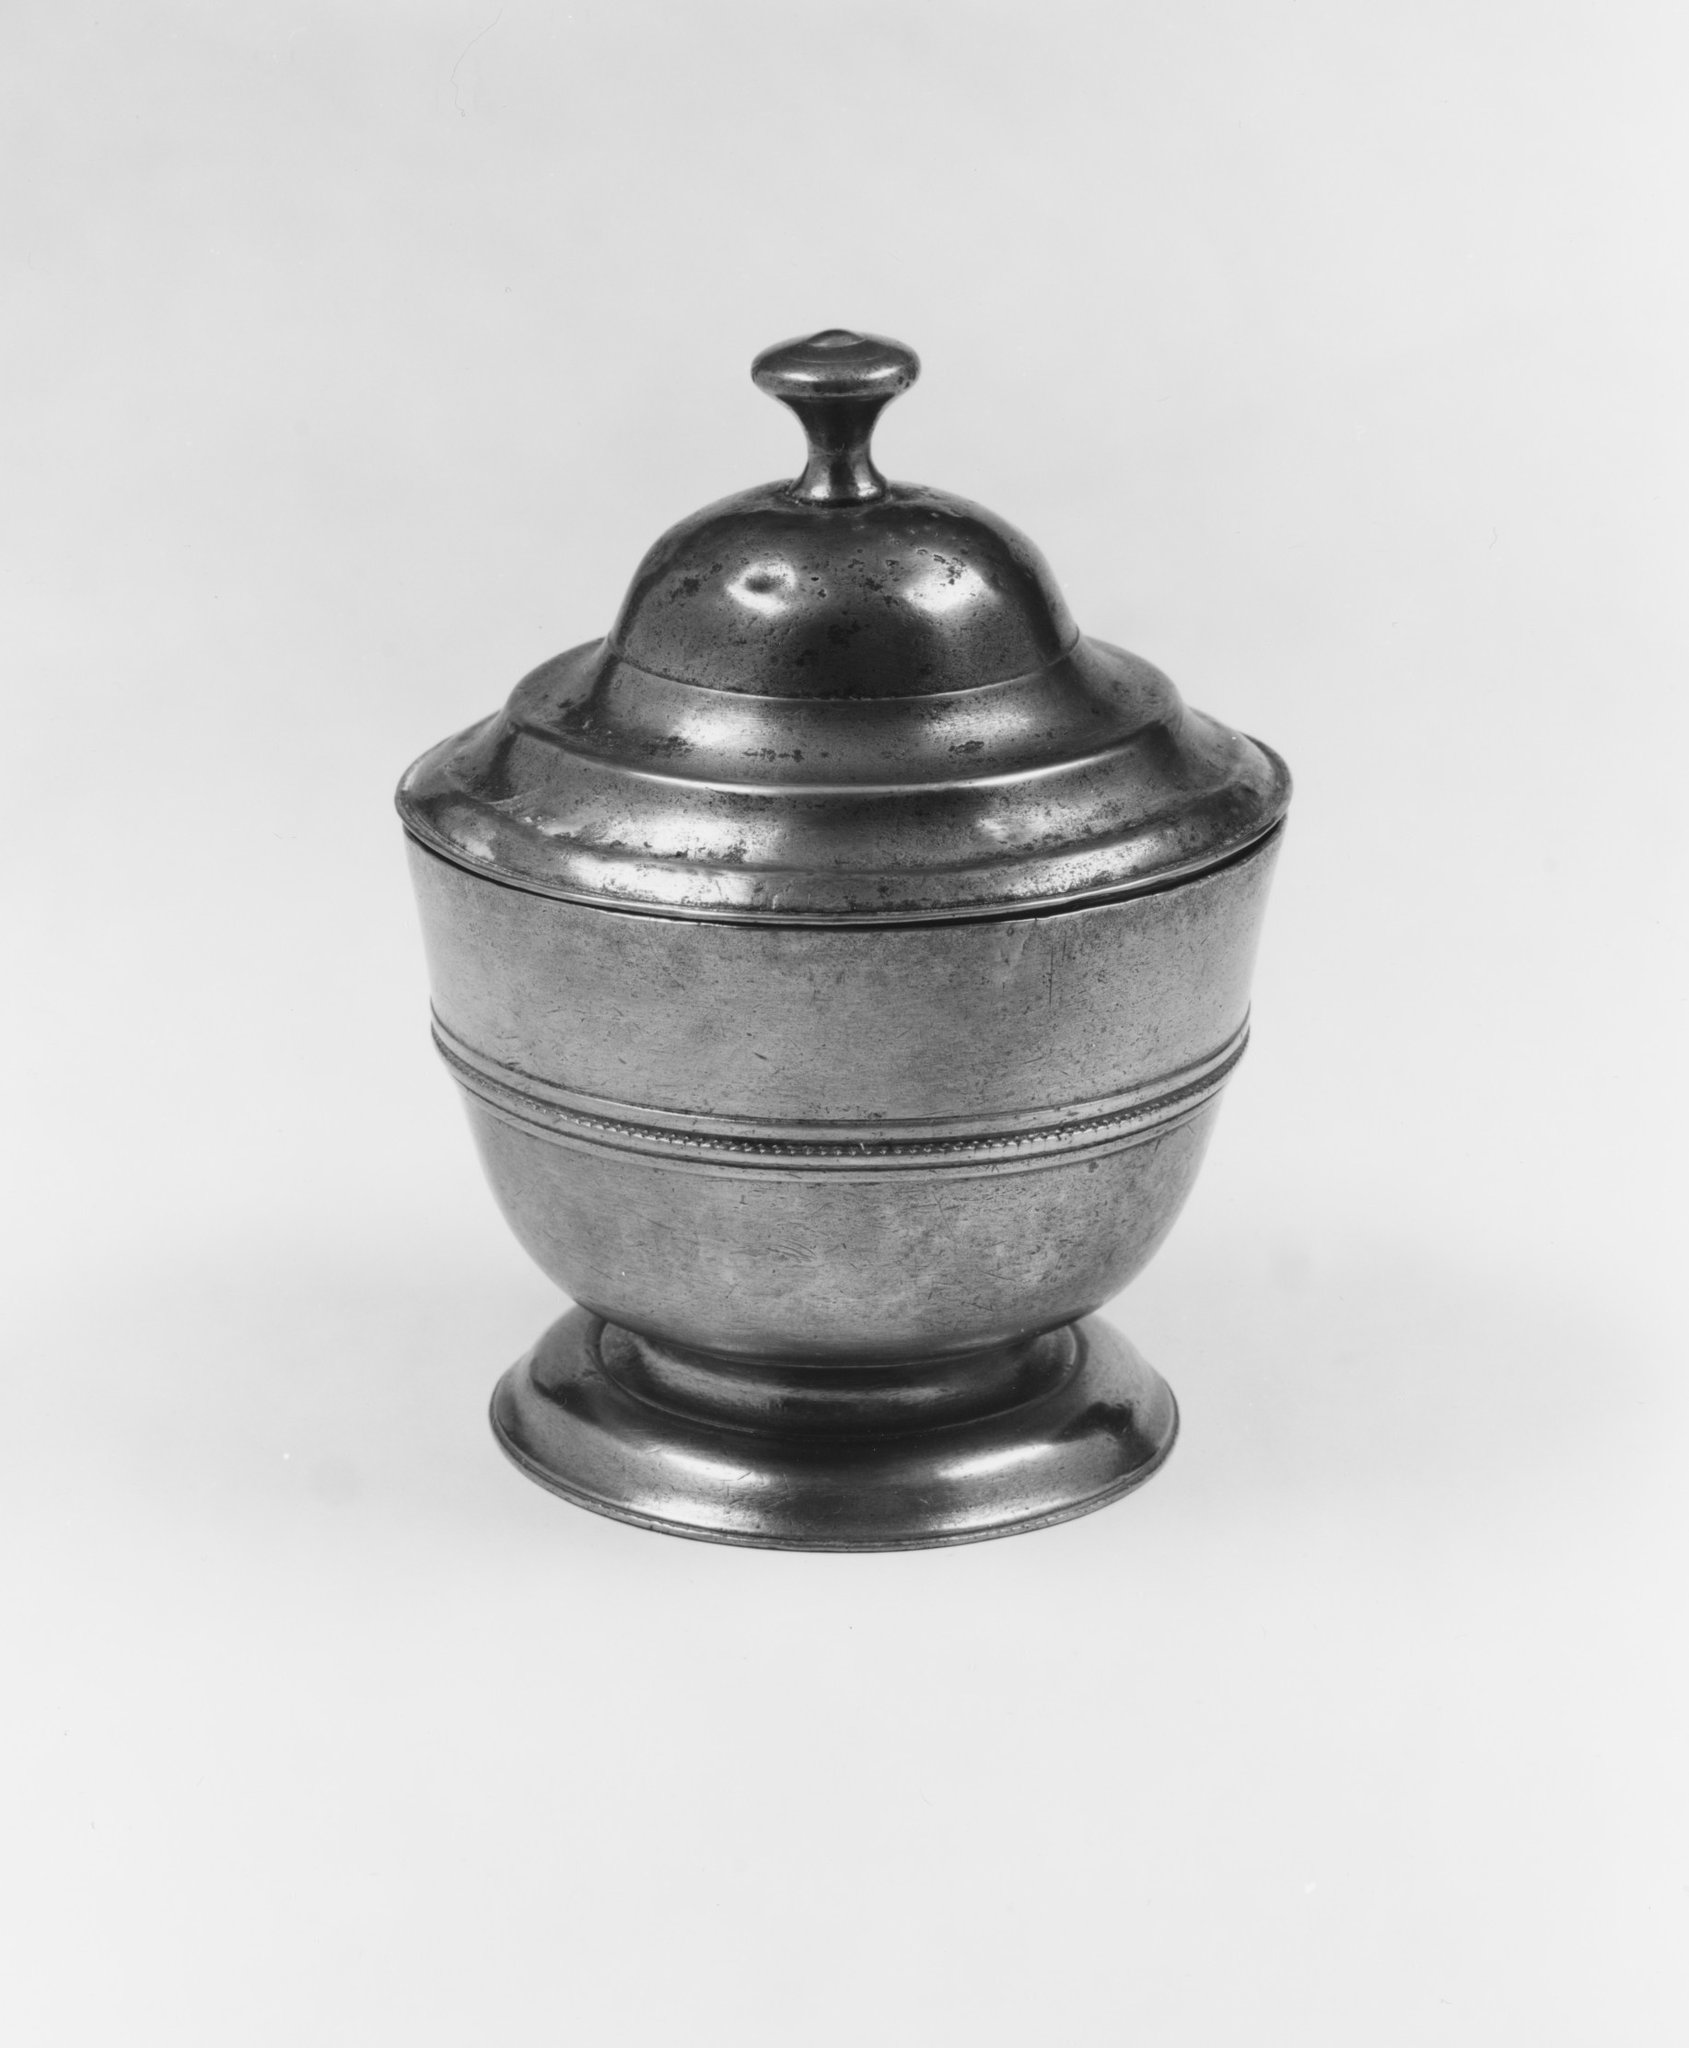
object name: sugar bowl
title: Covered Sugar Bowl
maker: henry will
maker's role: maker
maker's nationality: american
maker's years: 1734-1802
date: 1735-1802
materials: pewter